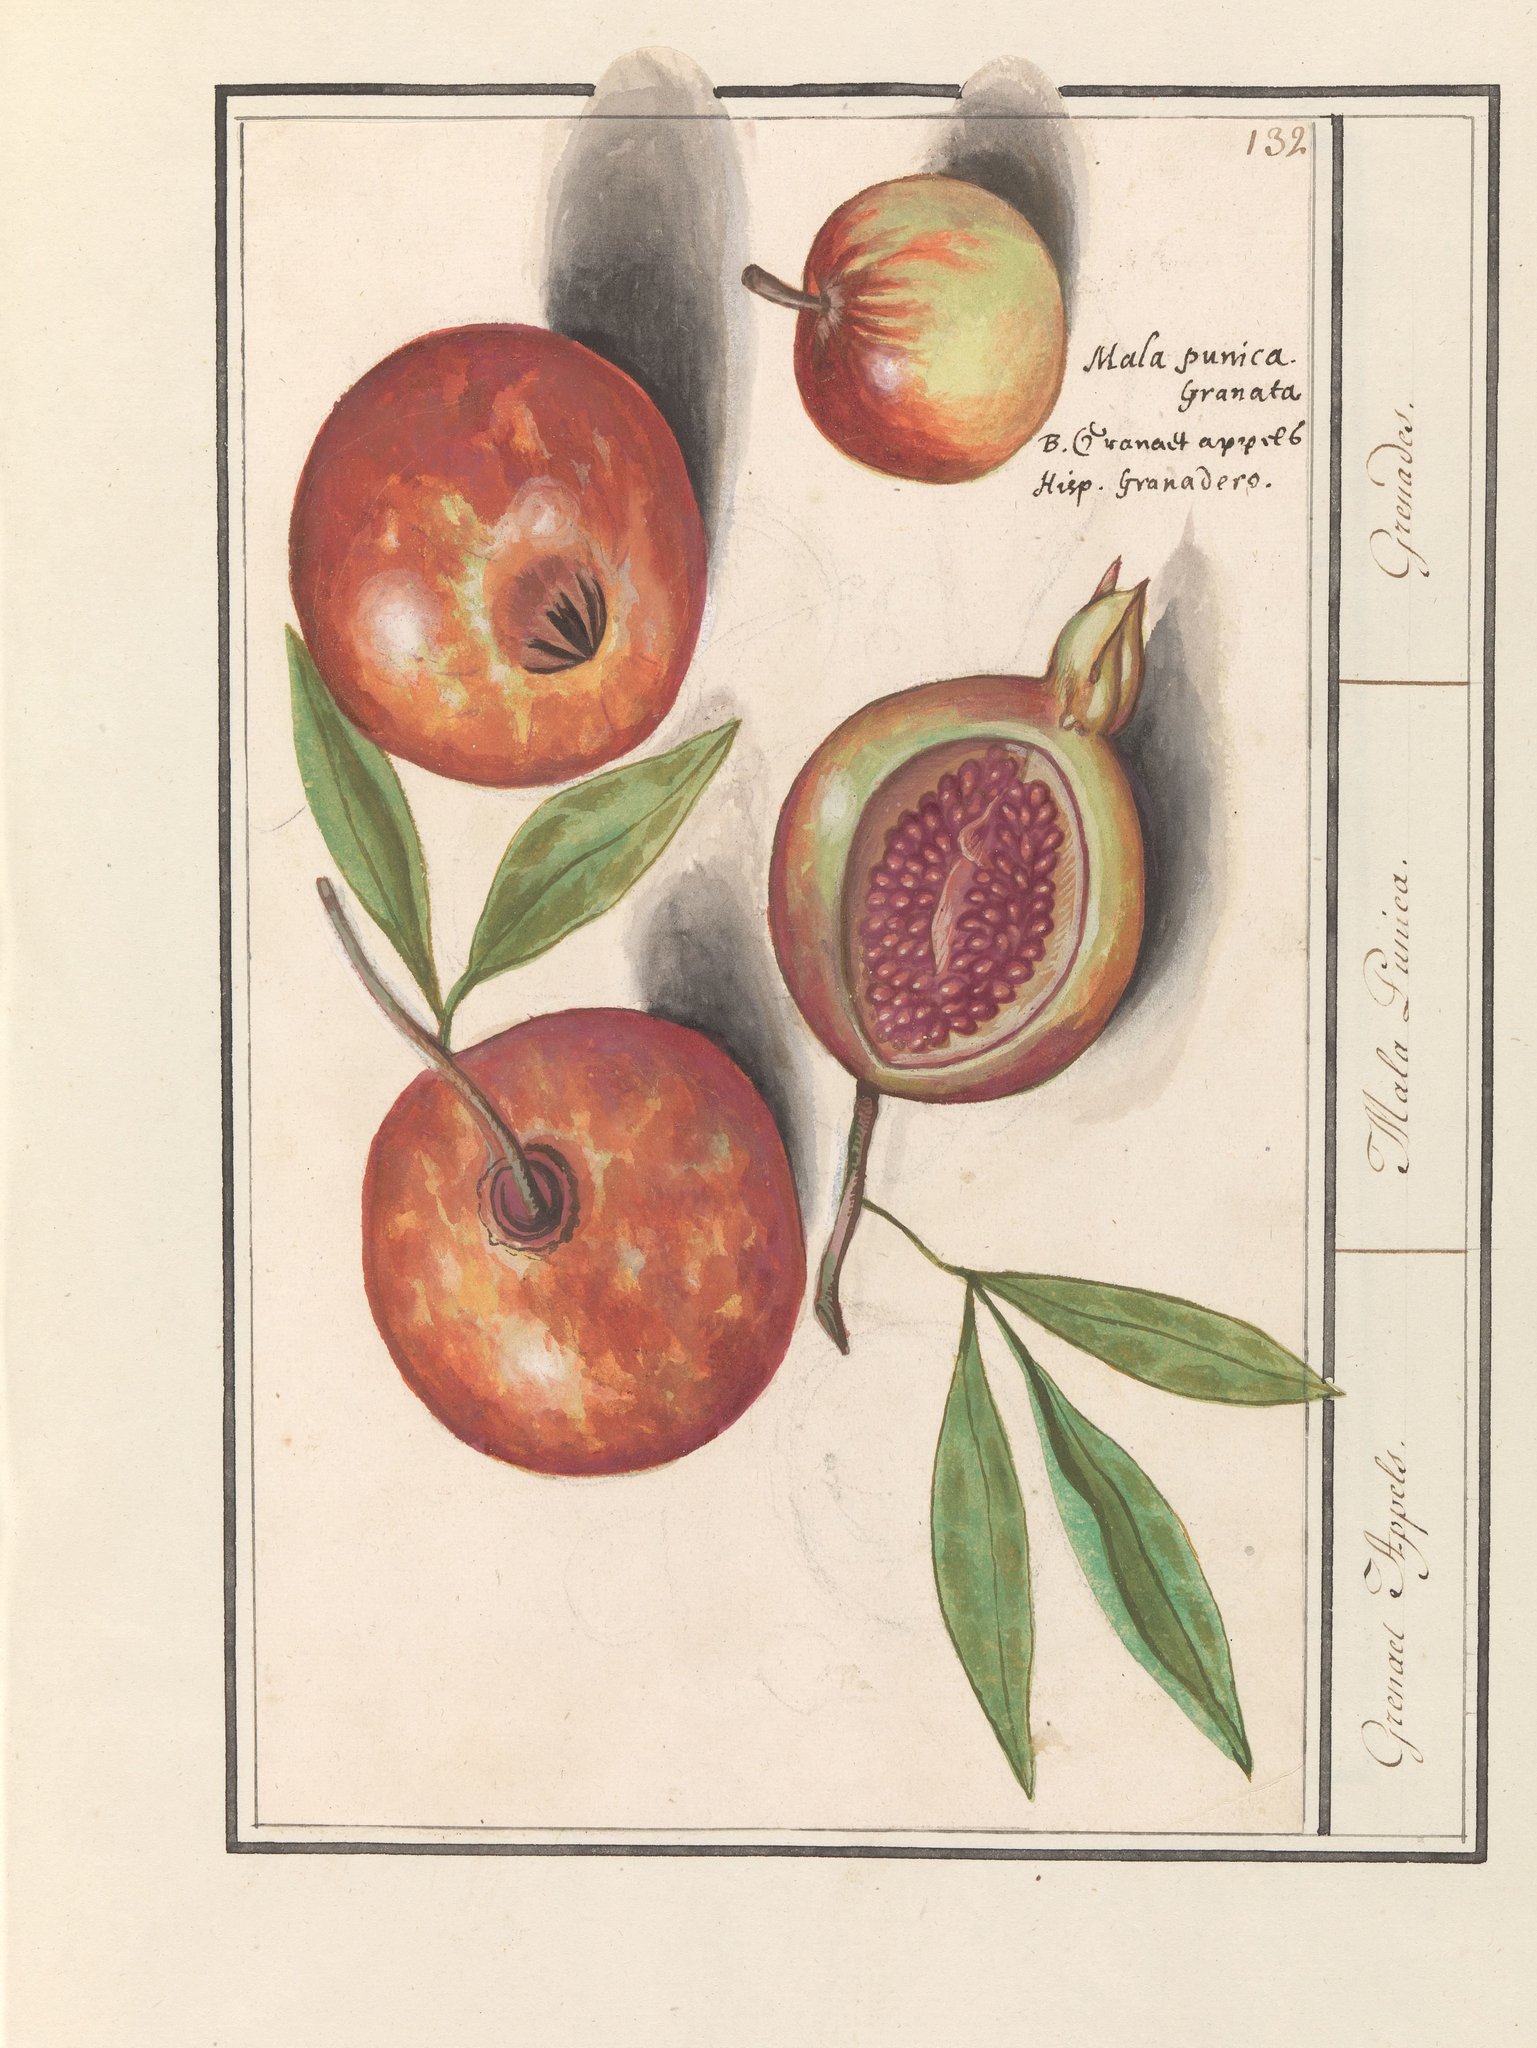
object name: drawing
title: Pomegranate (Punica granatum)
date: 1596-1610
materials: chalk, paint, ink, paper, watercolor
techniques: brush, pen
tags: fruits: pomegranate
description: This sheet is possibly one of the many botanical drawings in the albums made by the Delft flower painter Elias Verhulst, whom De Boodt commissioned for some 200 drawings. The shadows on the ground were probably added in the 19th century to suggest more volume. The Latin name of the plant, Punica, refers to the Phoenician people, said to have spread its cultivation from North Africa.